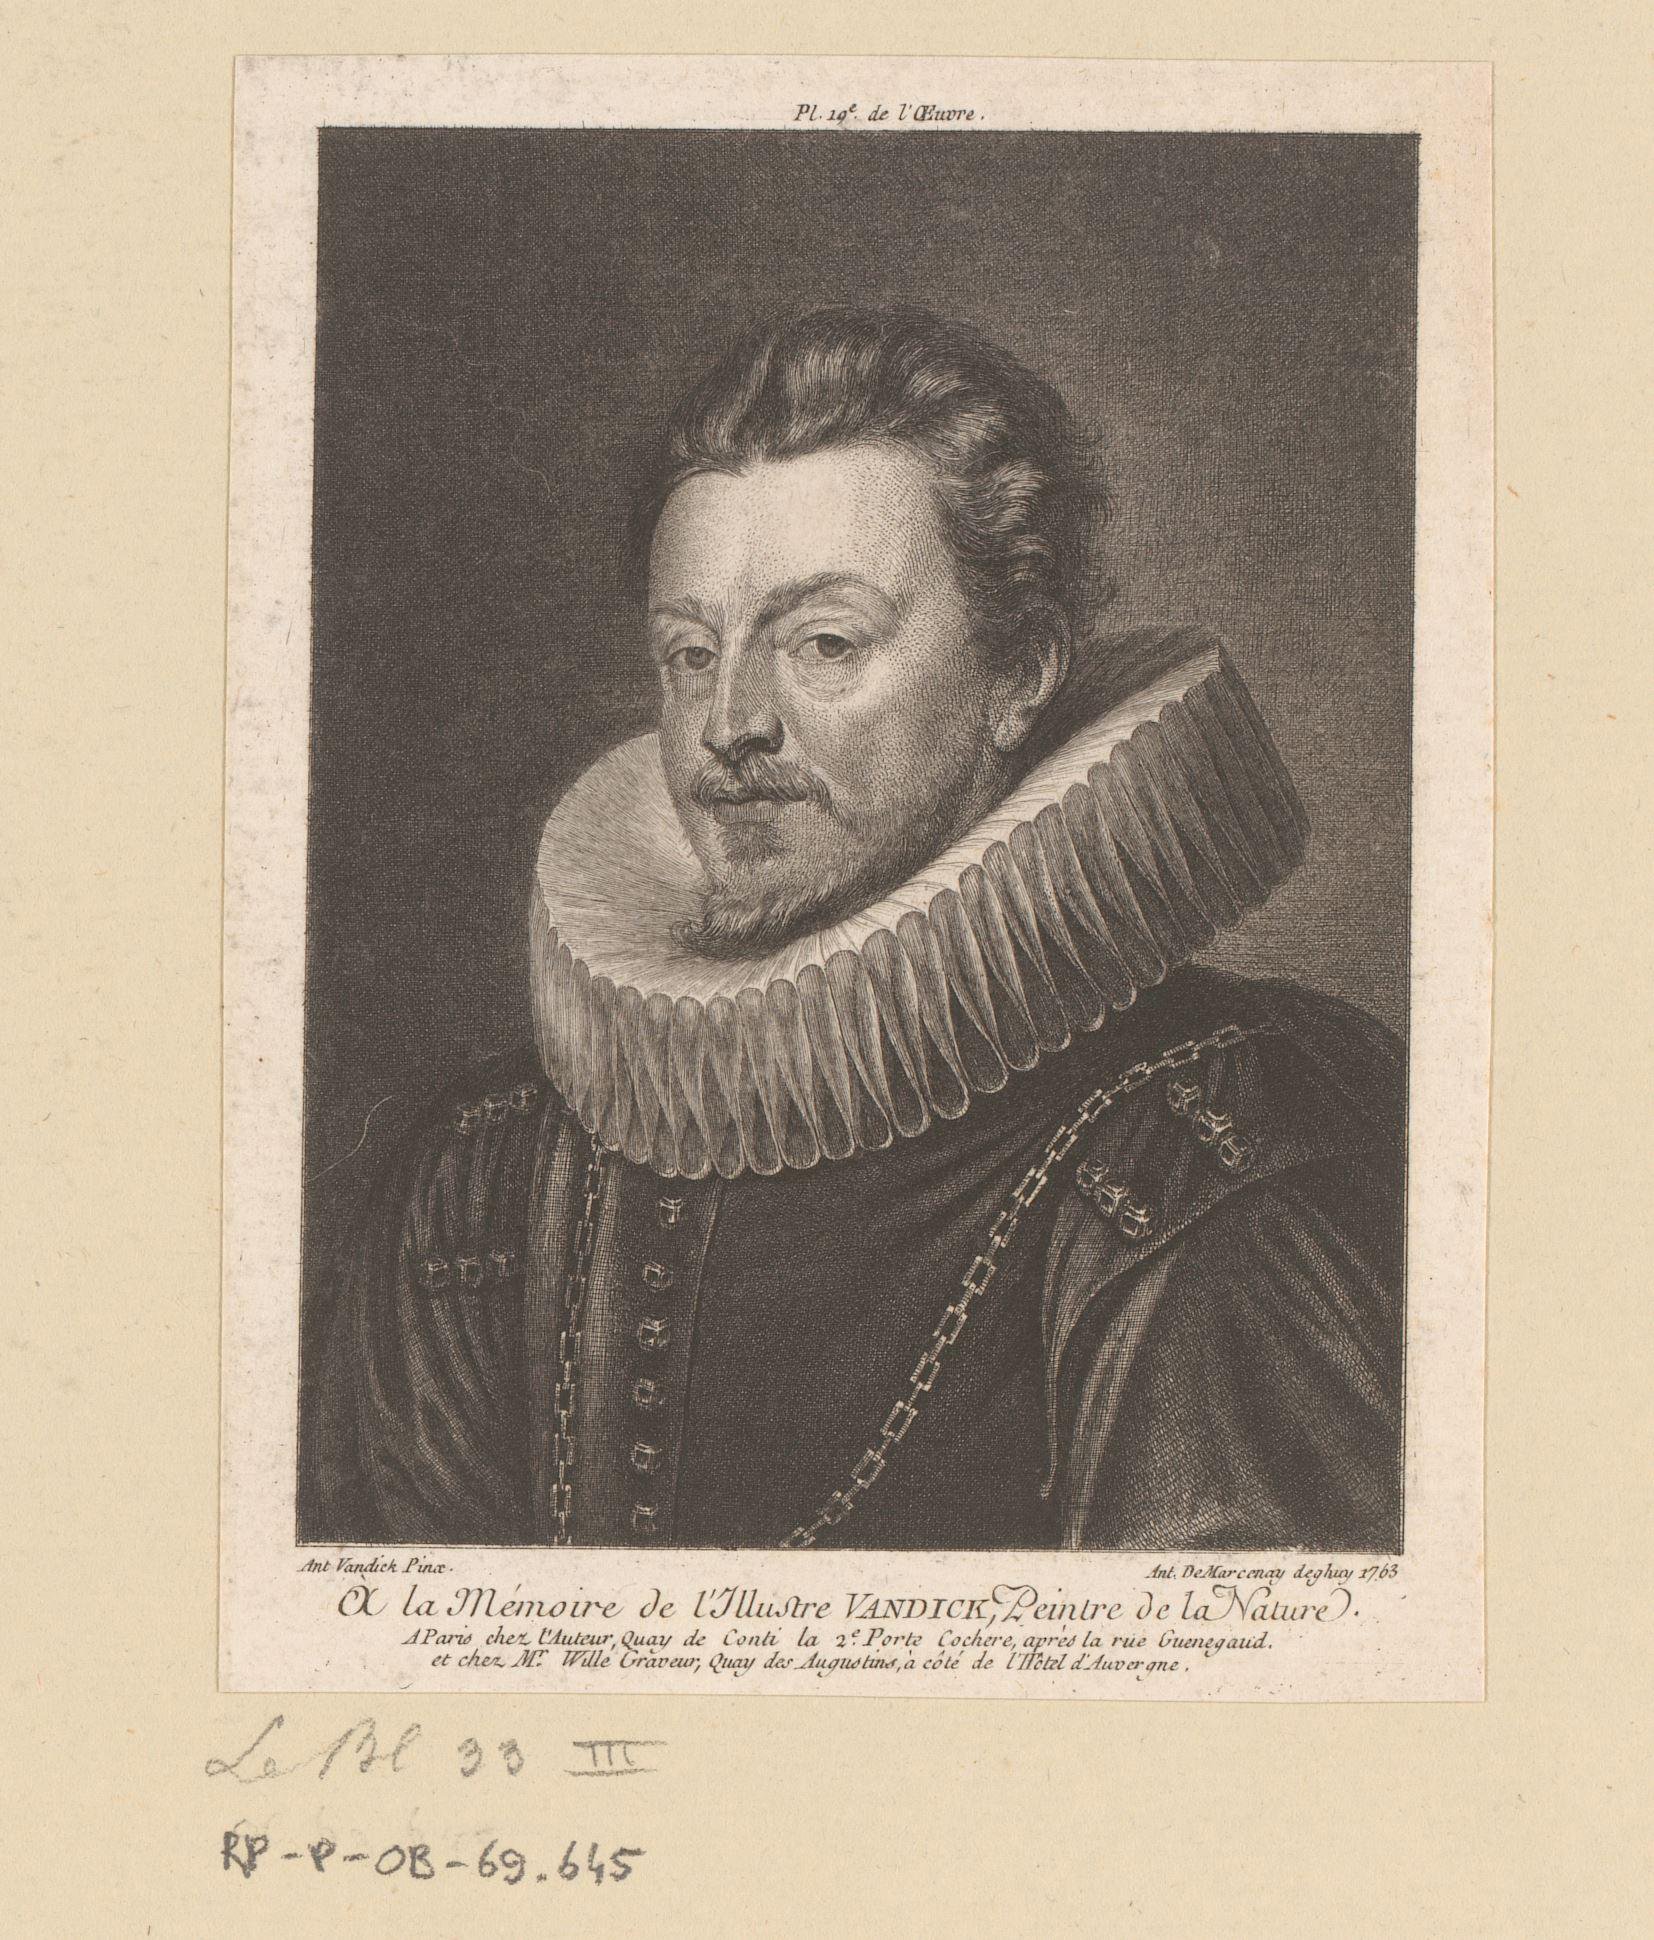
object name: print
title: Portret van een onbekende edelman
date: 1763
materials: paper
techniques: etching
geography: paris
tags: historical persons, neck-gear: collar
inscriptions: collector's mark: Lugt 2228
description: Genummerd midden boven: Pl. 19e de l'Oeuvre.